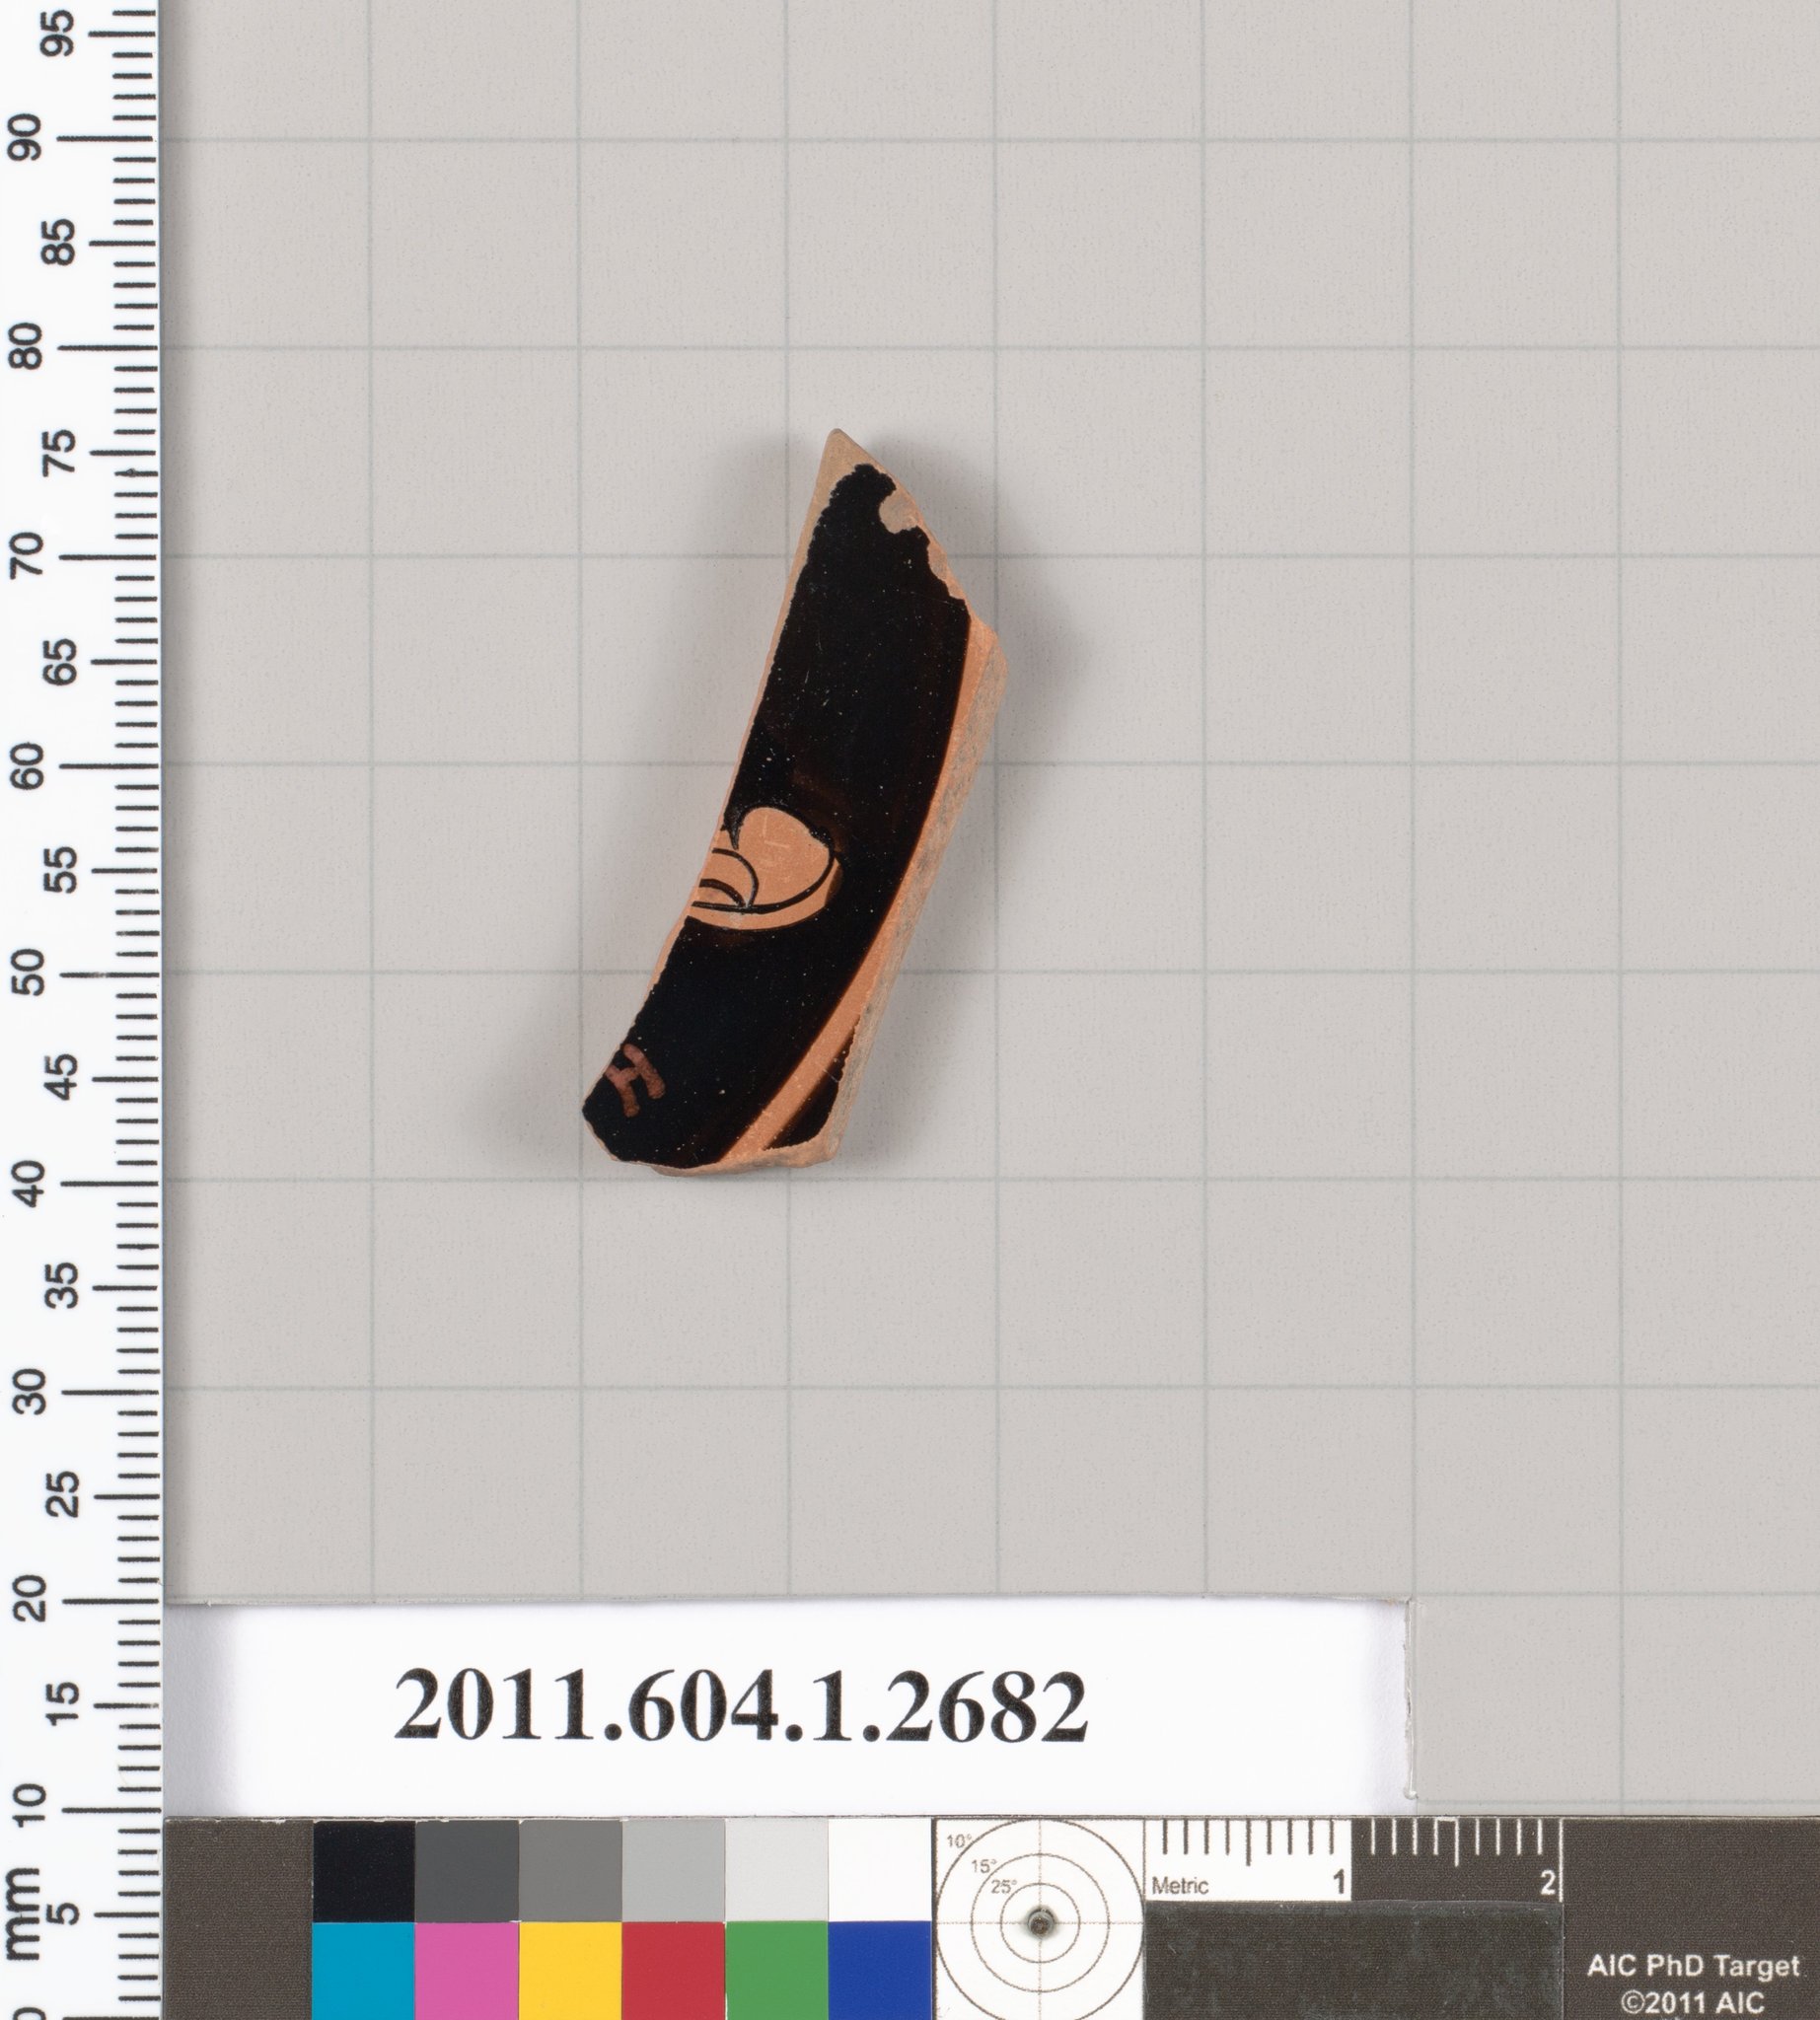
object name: kylix fragment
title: Terracotta fragment of a kylix (drinking cup)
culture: greek, attic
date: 500-480 BCE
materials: terracotta